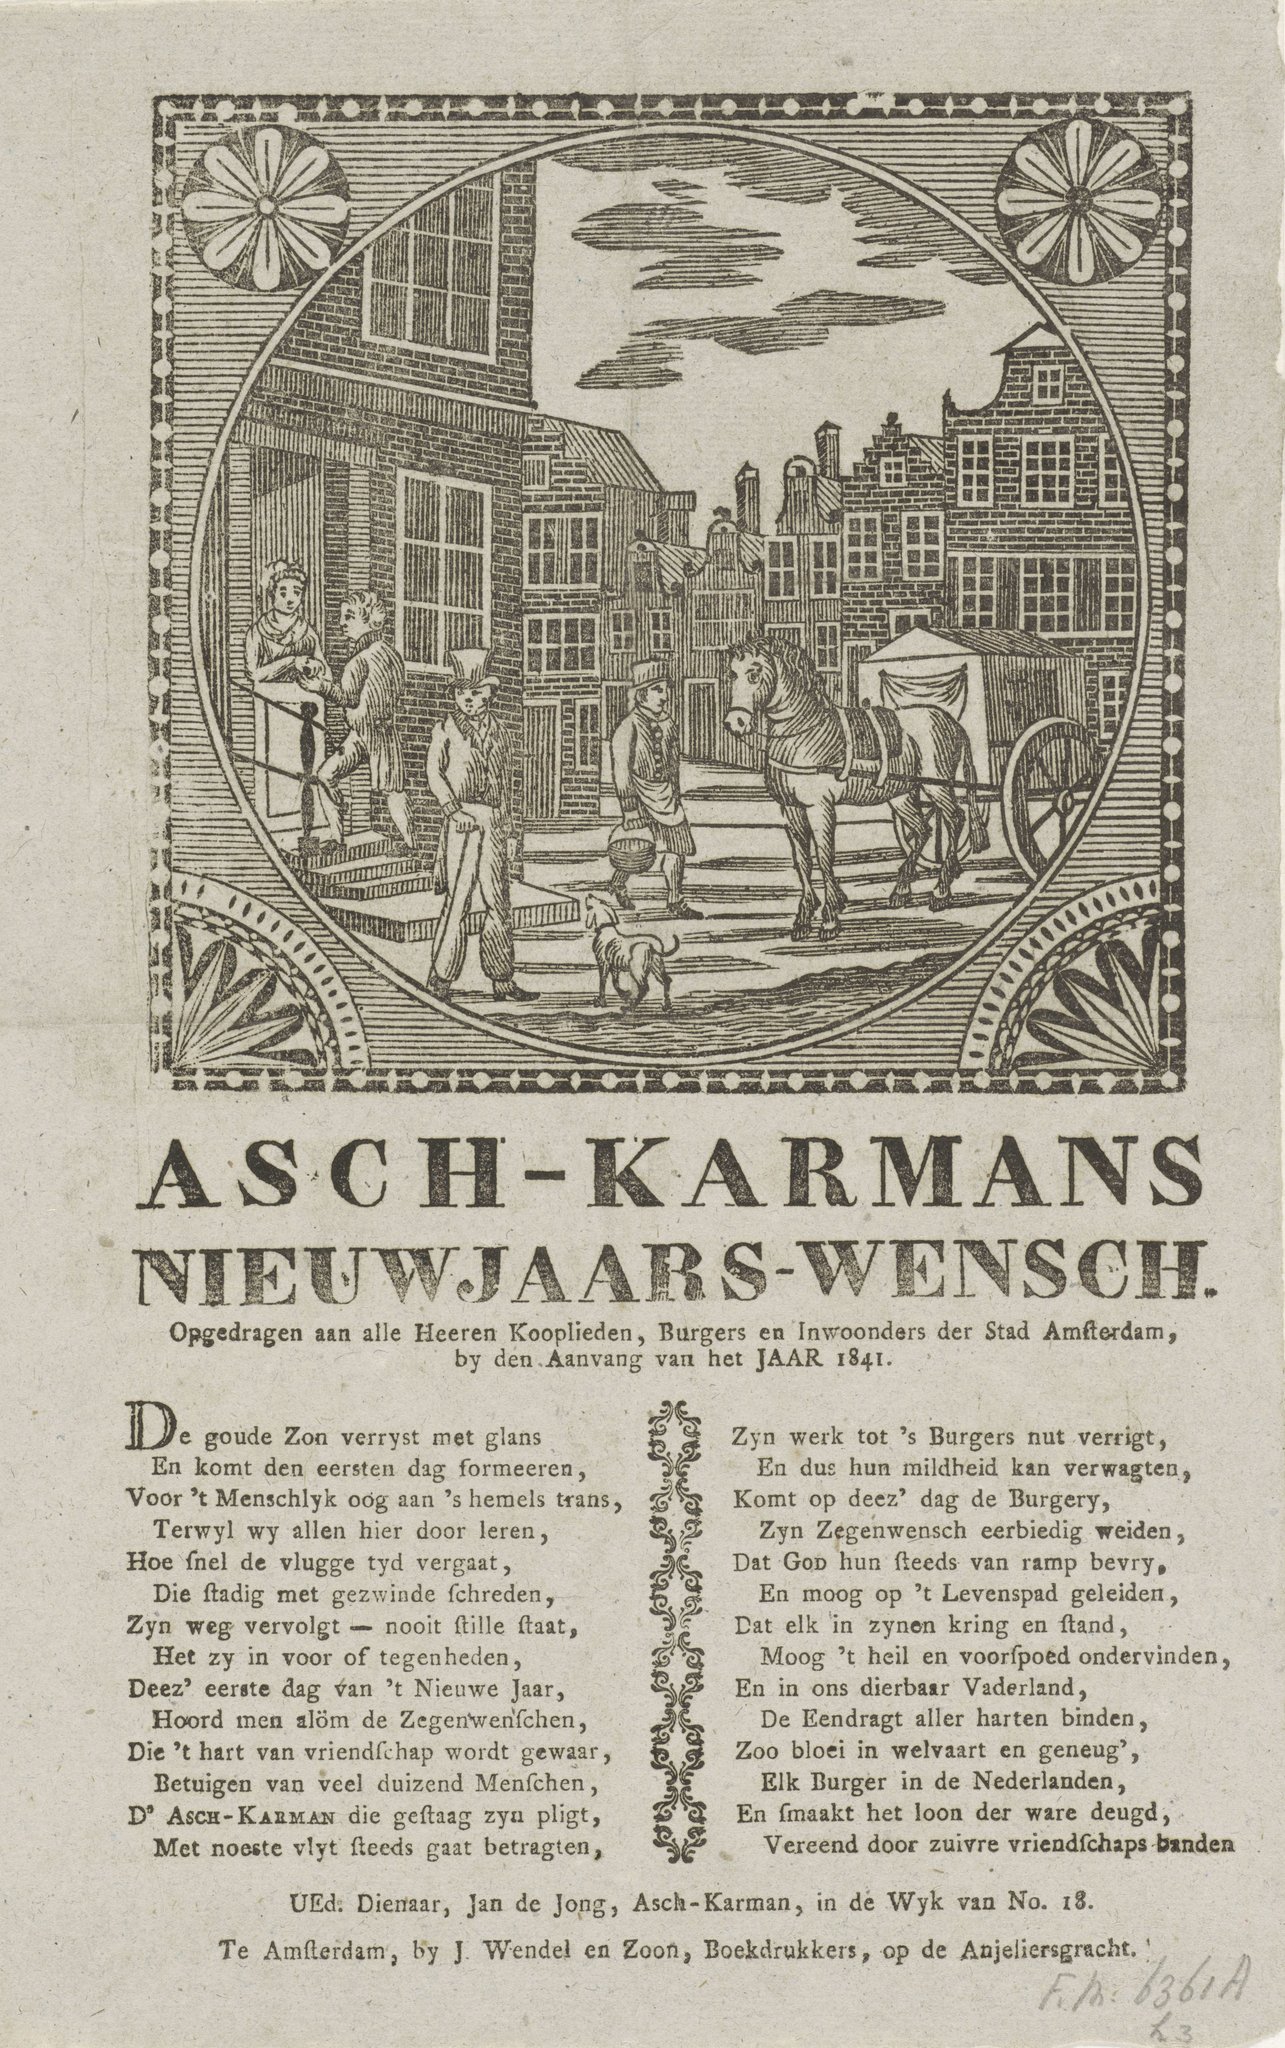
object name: print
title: Nieuwjaarswens van de Amsterdamse askarrenmannen voor het jaar 1841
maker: Anonymous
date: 1840-1841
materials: paper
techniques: letterpress printing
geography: amsterdam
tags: public road - ii - ideal city, garbage collection, amsterdam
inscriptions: collector's mark: Lugt 2228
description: Nieuwjaarswens namens de askarrenmannen (karrenman of vuilnisman) te Amsterdam voor het jaar 1841. Gezicht in een straat te Amsterdam waar een man asemmers naar de kar draagt terwijl een andere man aan huis geld ophaalt. Onderaan een gedicht in twee kolommen. Namens Jan de Jong, de askarreman van wijk no. 18.